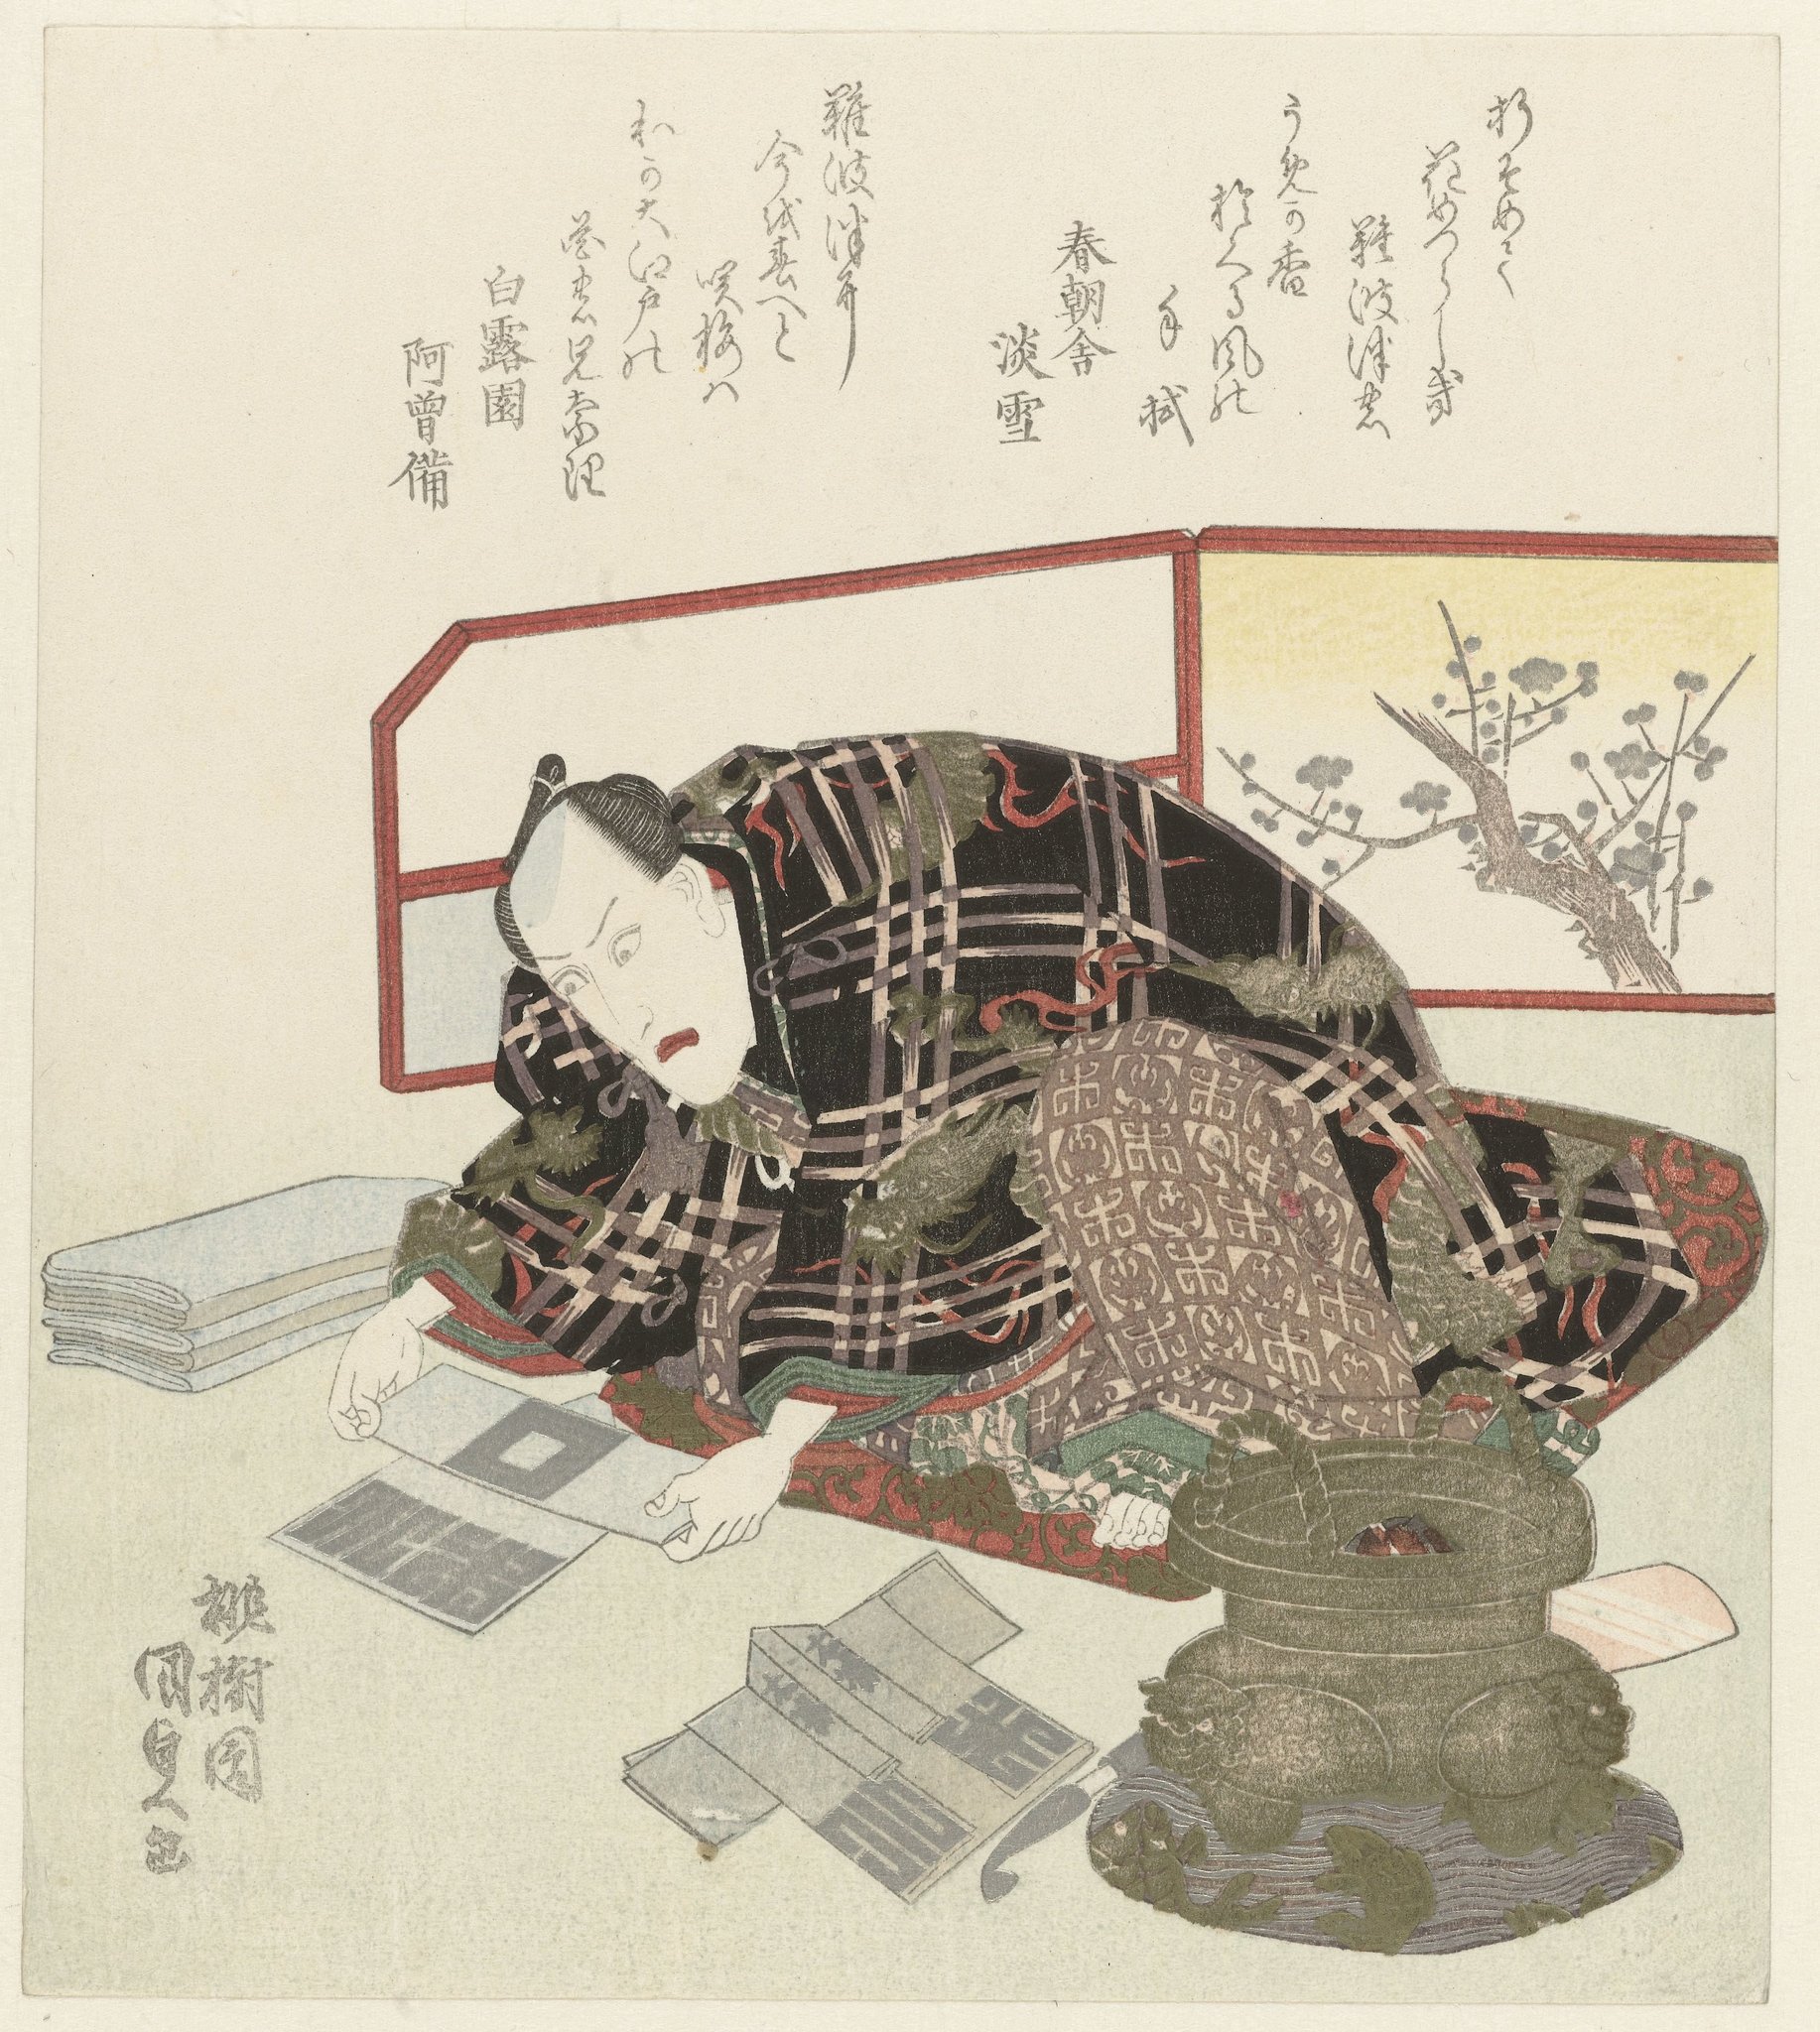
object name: surimono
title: A Man Folding Happi Coats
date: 1832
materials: paper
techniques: blind stamped, woodcut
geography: japan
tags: fashion, clothing, sitting on the ground, screen, folding screen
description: Een man in een kimono met een geometrisch patroon en drakenmotief, zit voorovergebogen naast een komfoor waarnaast een pijp ligt. Met het stapeltje stof rechts van hem vouwt hij kleine, korte kimono`s, zogenaamde 'happi `s'. Op de achtergrond een laag kamerscherm met een afbeelding van pruimenbloesem. Het drakenmotief op zijn kimono verwijst waarschijnlijk naar het nieuwe jaar van de draak, 1832. Met twee gedichten.